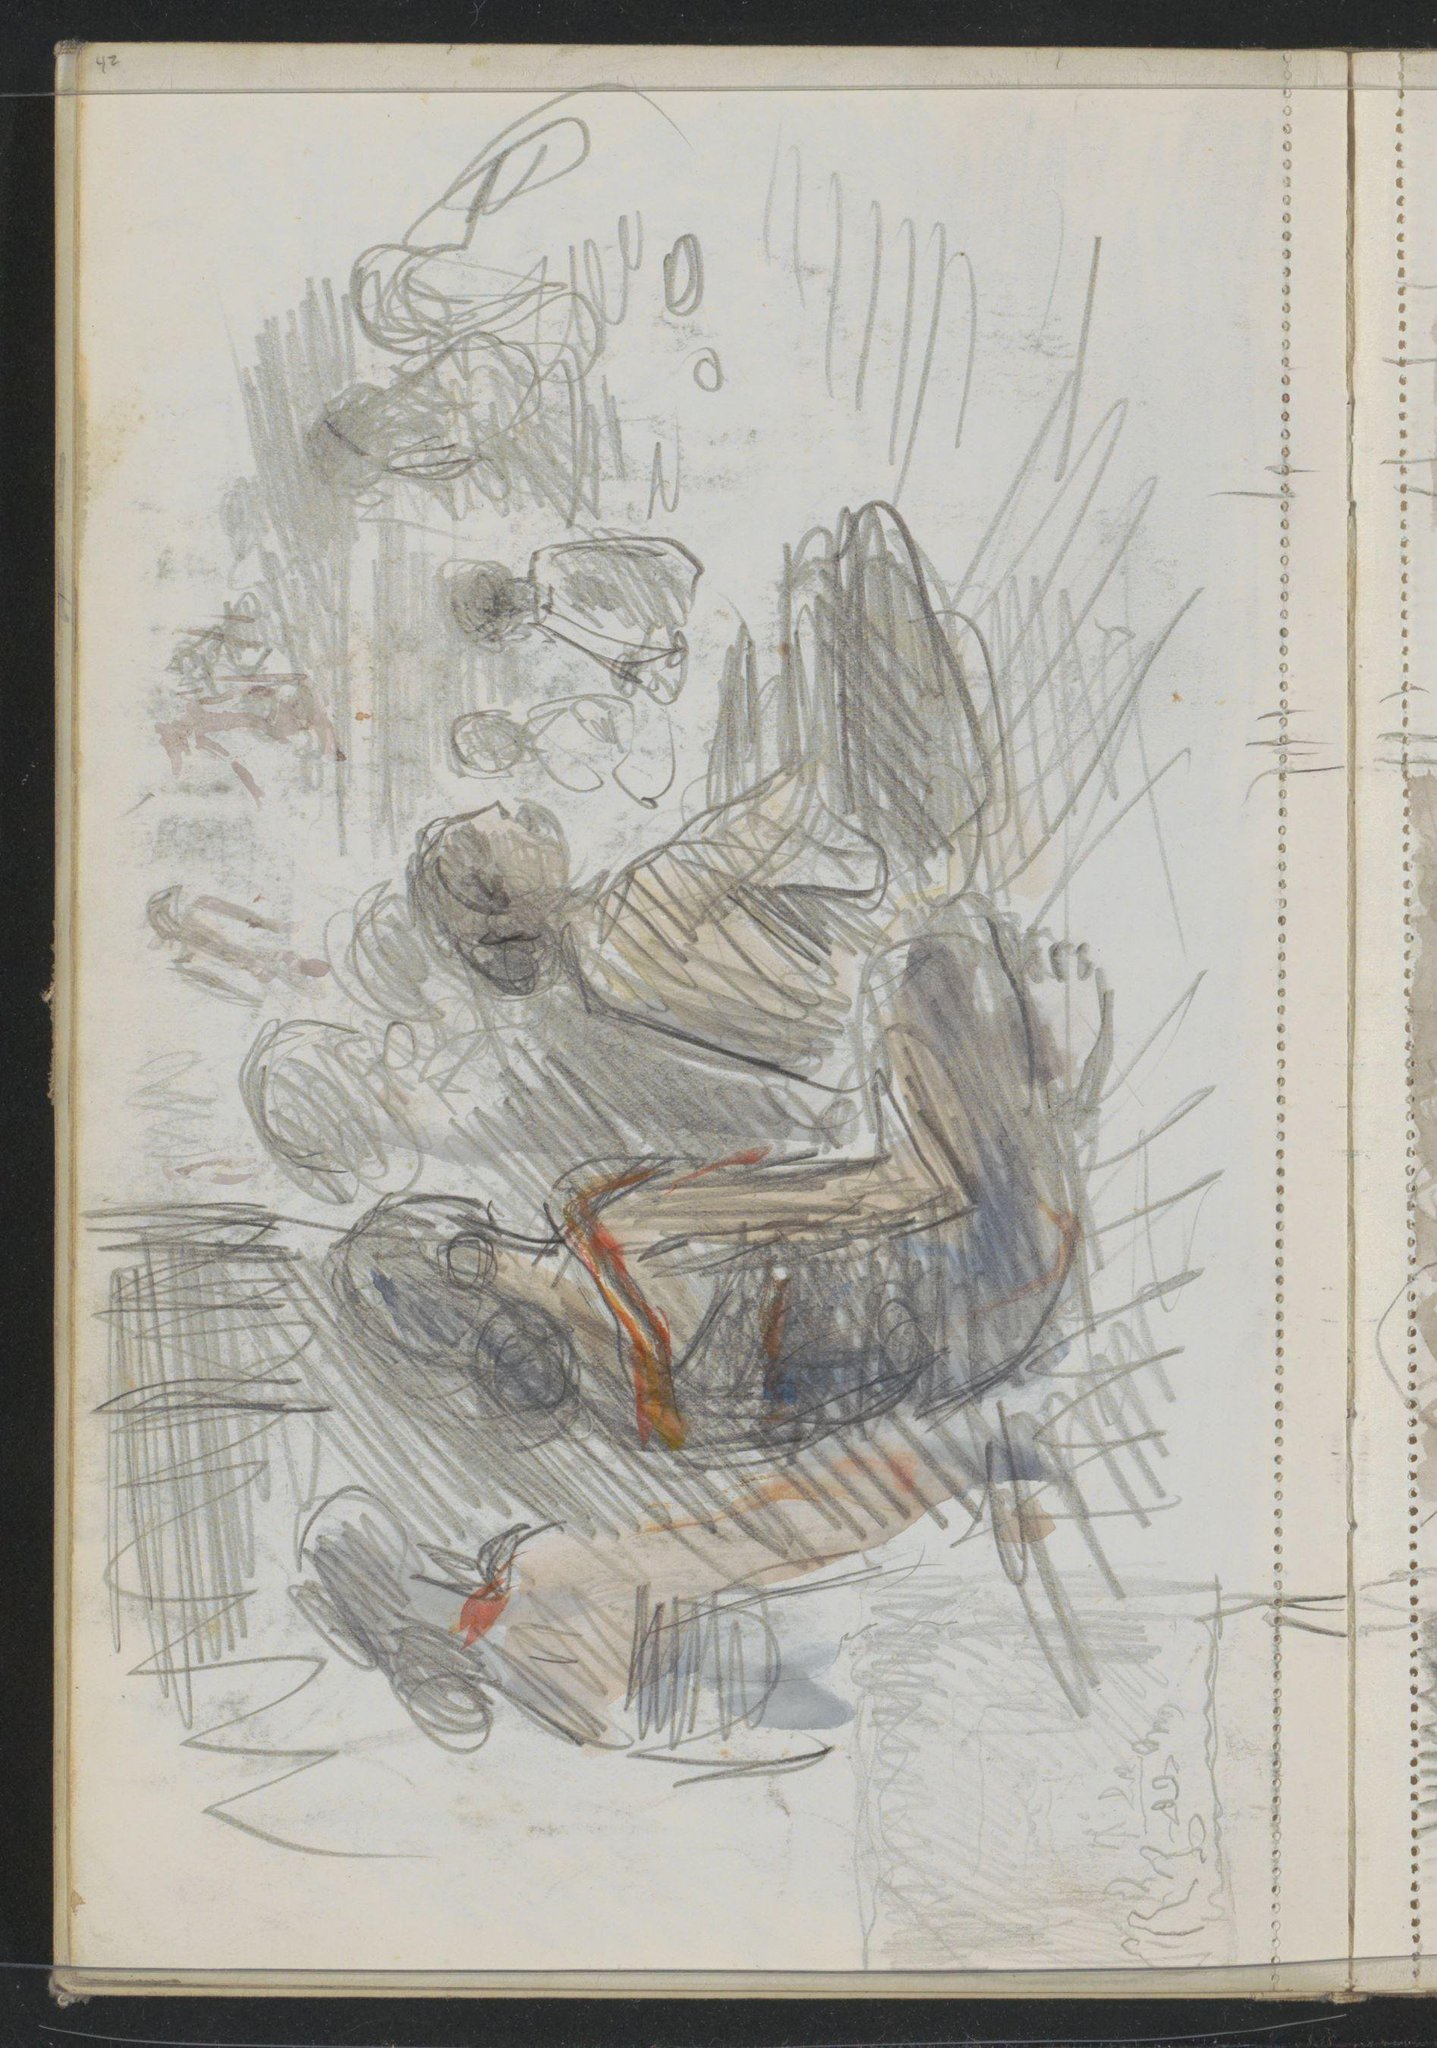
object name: sketchbook leaf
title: Zittende toeschouwers bij een podium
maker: marius bauer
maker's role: draughtsman, print maker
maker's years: 1867-1932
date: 1925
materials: paper, pencil, watercolor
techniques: brush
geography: indonesia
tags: set, scenery ~ stage, sitting figure, the audience ~ art performance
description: De vrouwen dragen traditioneel kostuum. Pagina 42 uit een schetsboek met 74 bladen.